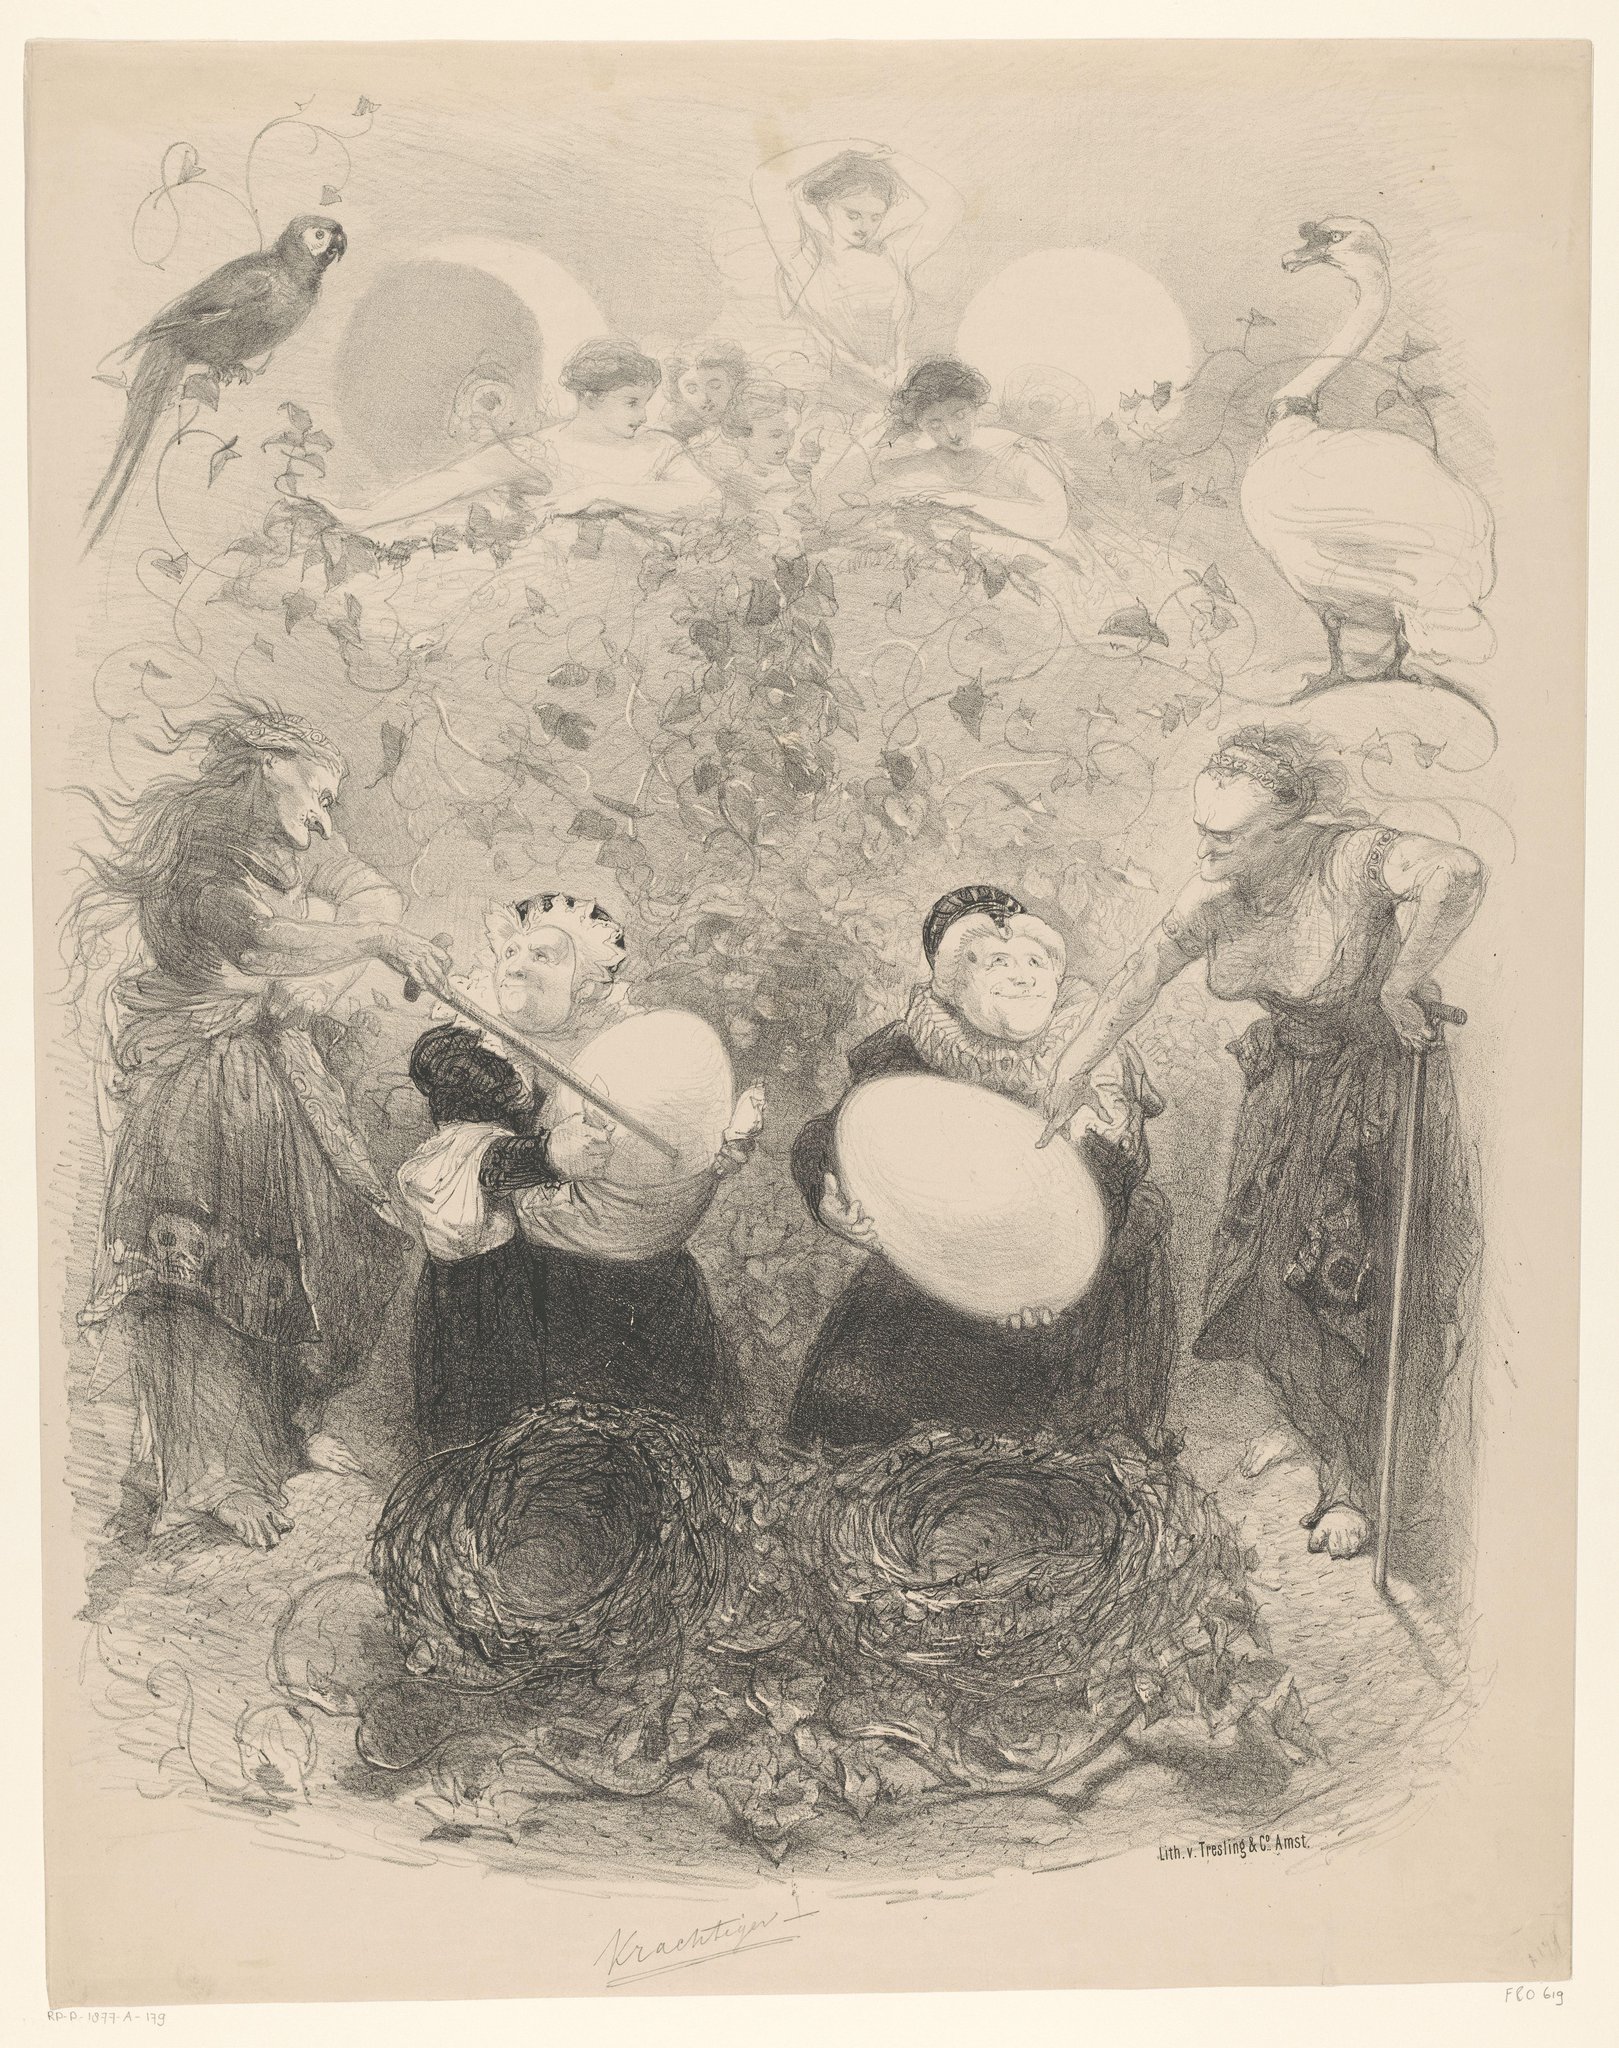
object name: print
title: Balletscène met oude vrouwen met eieren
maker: charles rochussen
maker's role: draughtsman, painter, print maker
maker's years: 1814-1894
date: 1865-1868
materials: paper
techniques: lithograph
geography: netherlands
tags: the ballet, ballet performance, old woman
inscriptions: collector's mark: Lugt 2228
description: Twee oude vrouwen houden een ei in hun hand boven een leeg nest. Naast hen staan twee heksen, die met hun stok en hand op de eieren wijzen. Vanaf de bovenzijde kijkt een groep jonge vrouwen toe.